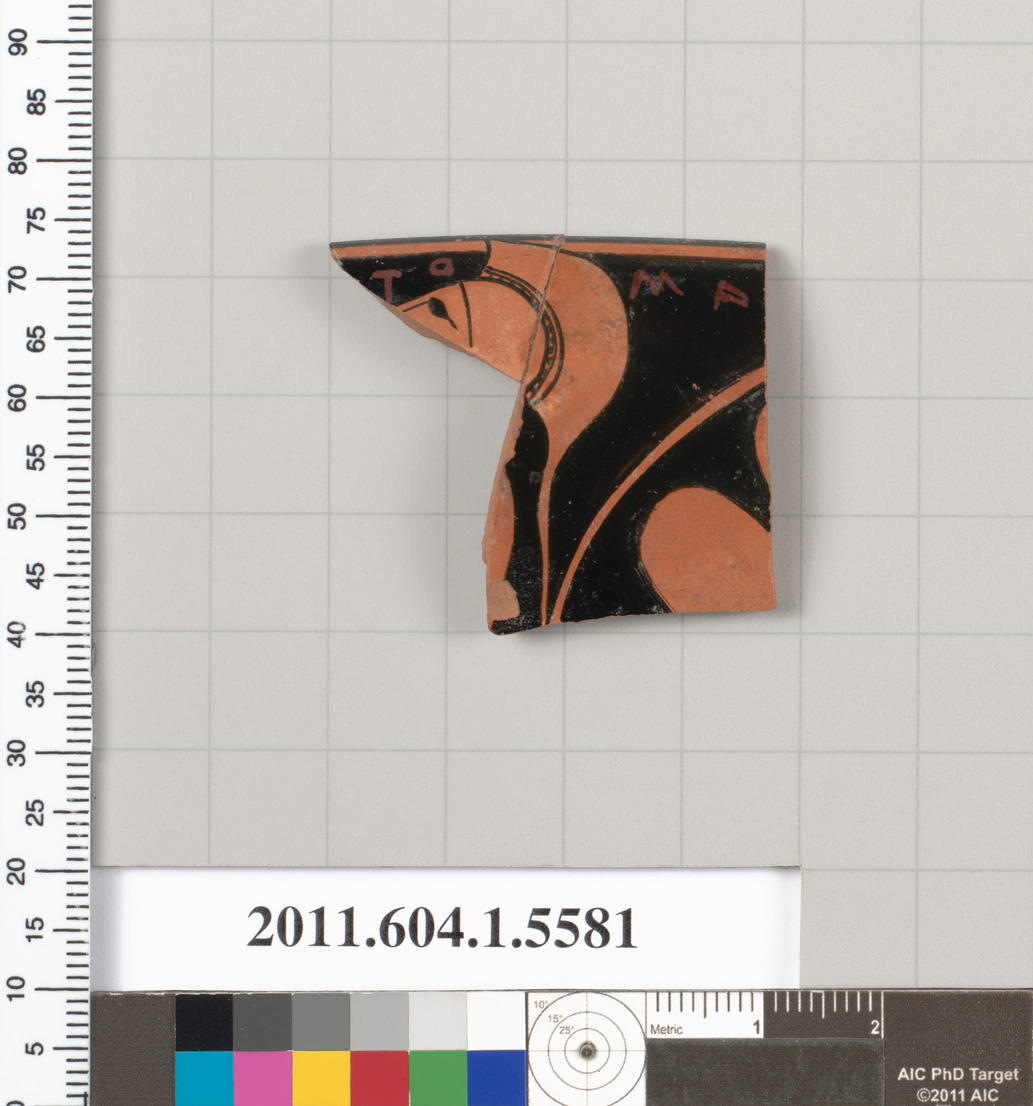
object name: kylix fragment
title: Terracotta rim fragment of a kylix (drinking cup)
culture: greek, attic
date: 520-510 BCE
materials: terracotta